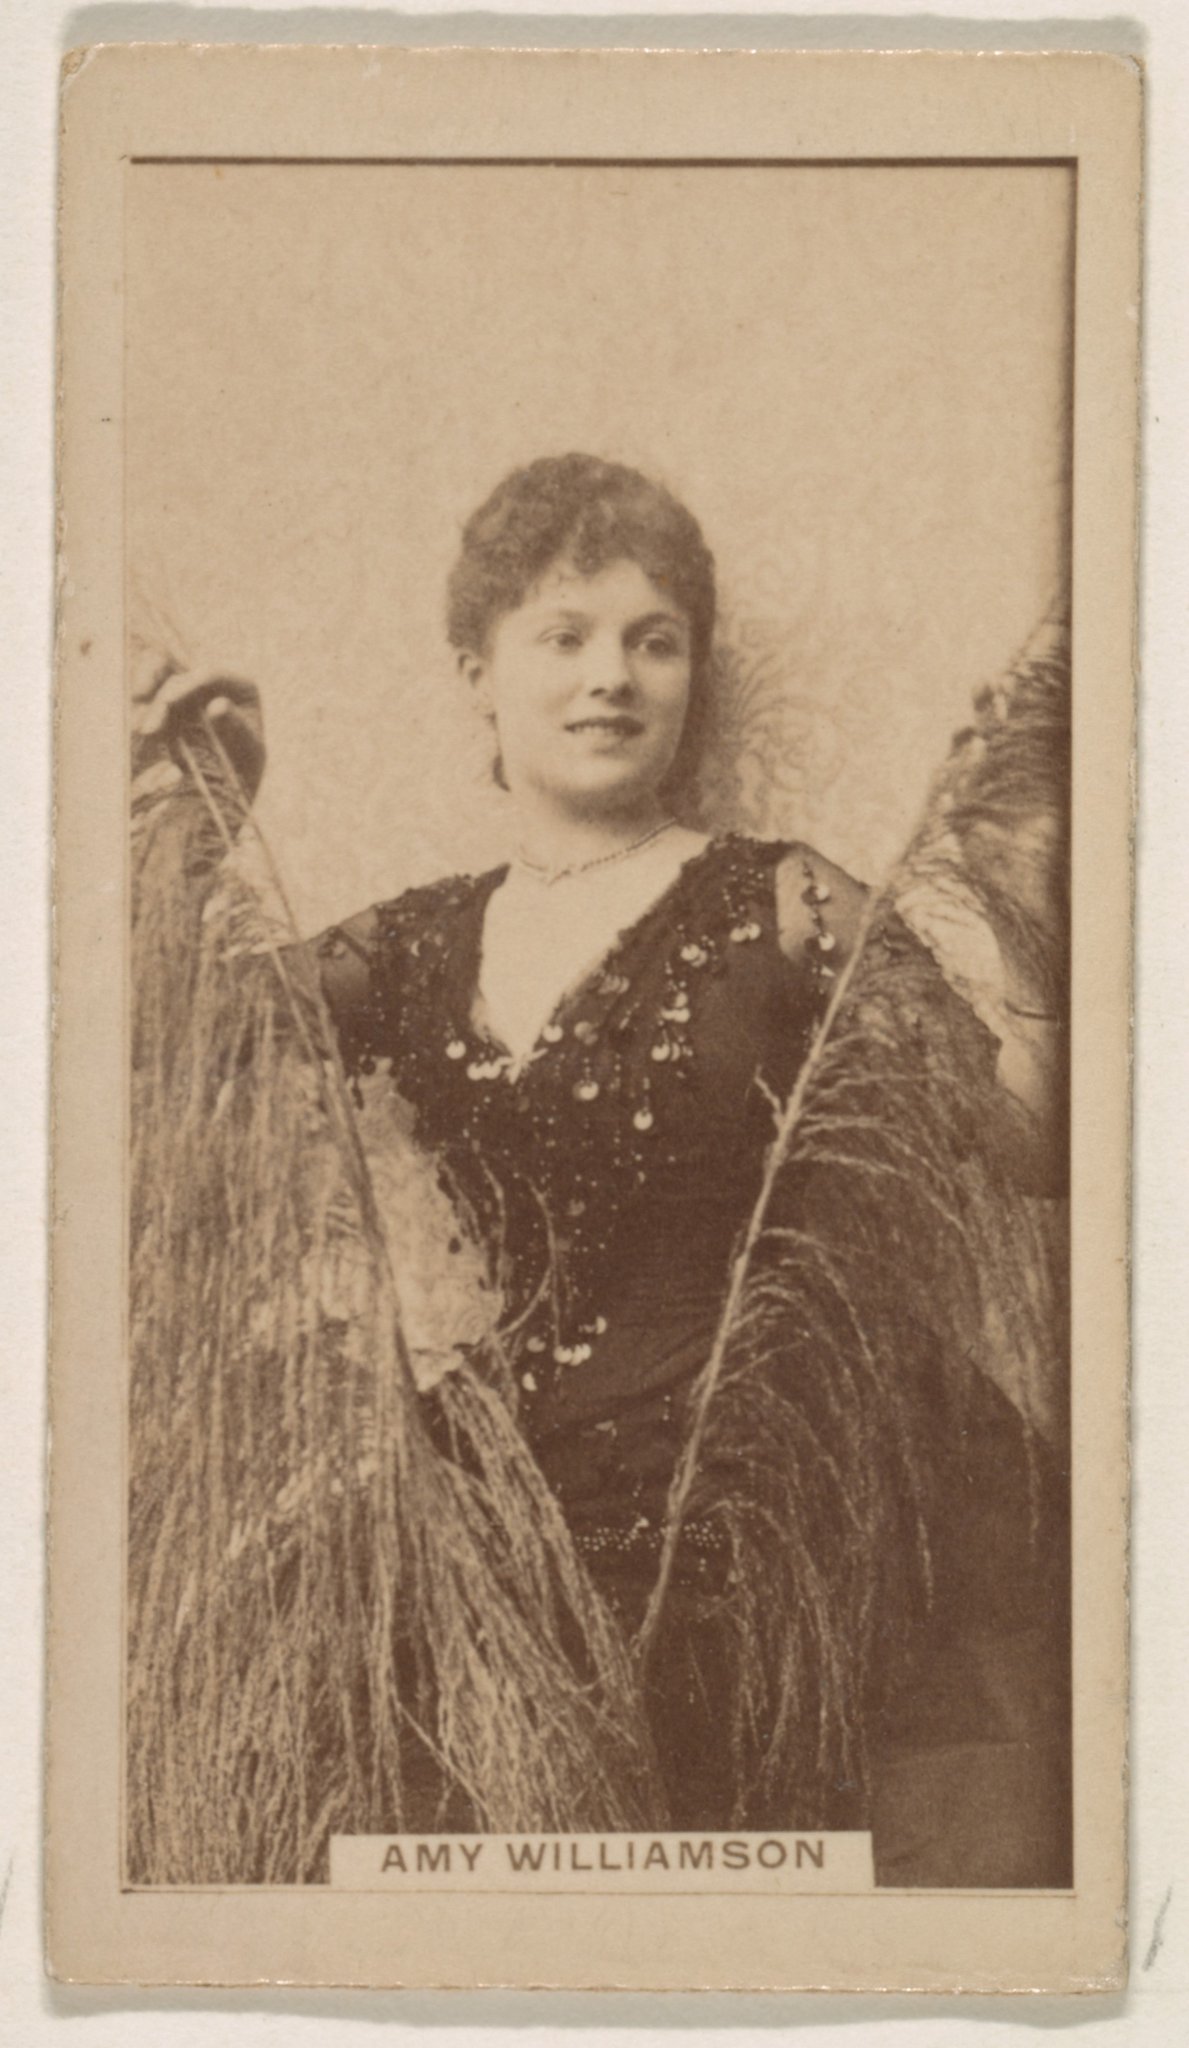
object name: photograph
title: Amy Williamson, from the Actresses series (N245) issued by Kinney Brothers to promote Sweet Caporal Cigarettes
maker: kinney brothers tobacco company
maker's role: publisher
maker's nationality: american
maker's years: 1869-2011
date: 1890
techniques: albumen silver print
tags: portraits,women,actresses